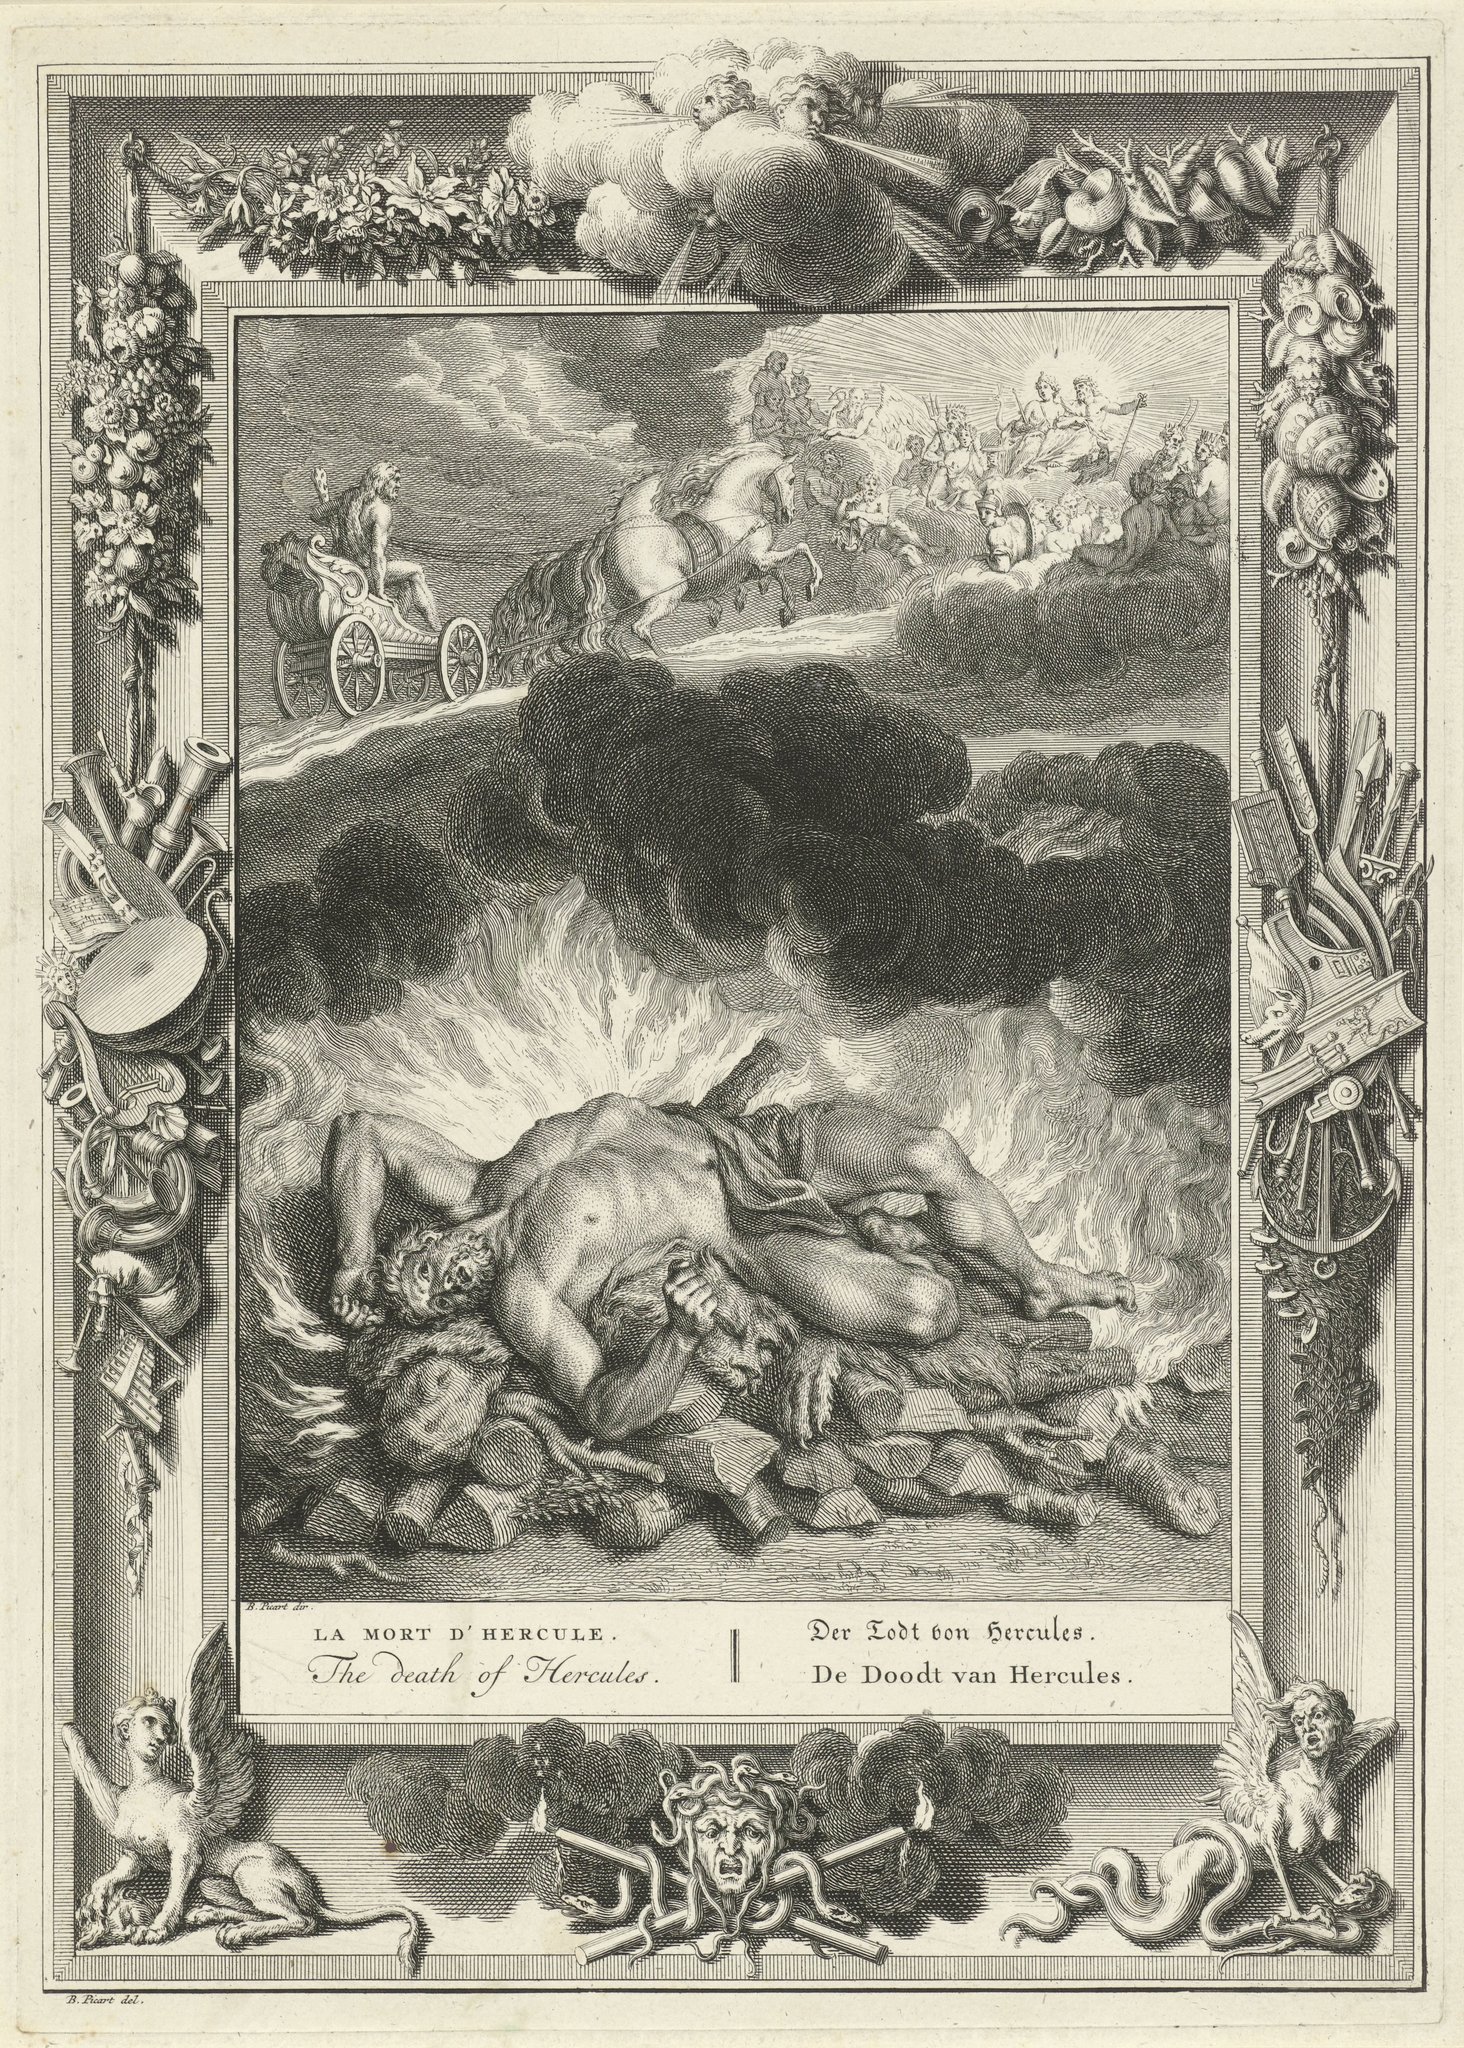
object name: print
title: Hercules op de brandstapel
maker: bernard picart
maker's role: draughtsman, print maker, publisher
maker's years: 1673-1733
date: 1733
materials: paper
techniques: engraving, etching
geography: amsterdam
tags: scrollwork, strapwork ~ ornament, death of hercules, apotheosis of hercules: he is borne to heaven in a four-horse chariot and reconciled with juno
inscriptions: collector's mark: Lugt 240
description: Hercules ligt achterover op de brandstapel. Na zijn dood wordt Hercules in de wagen van Minerva omhoog gevoerd naar Jupiter, om zijn plaats in te nemen tussen de twaalf goden van de Olympus. In de marge de titel in het Frans, Engels, Duits en Nederlands. De voorstelling is gedecoreerd met een ornamentele rand.